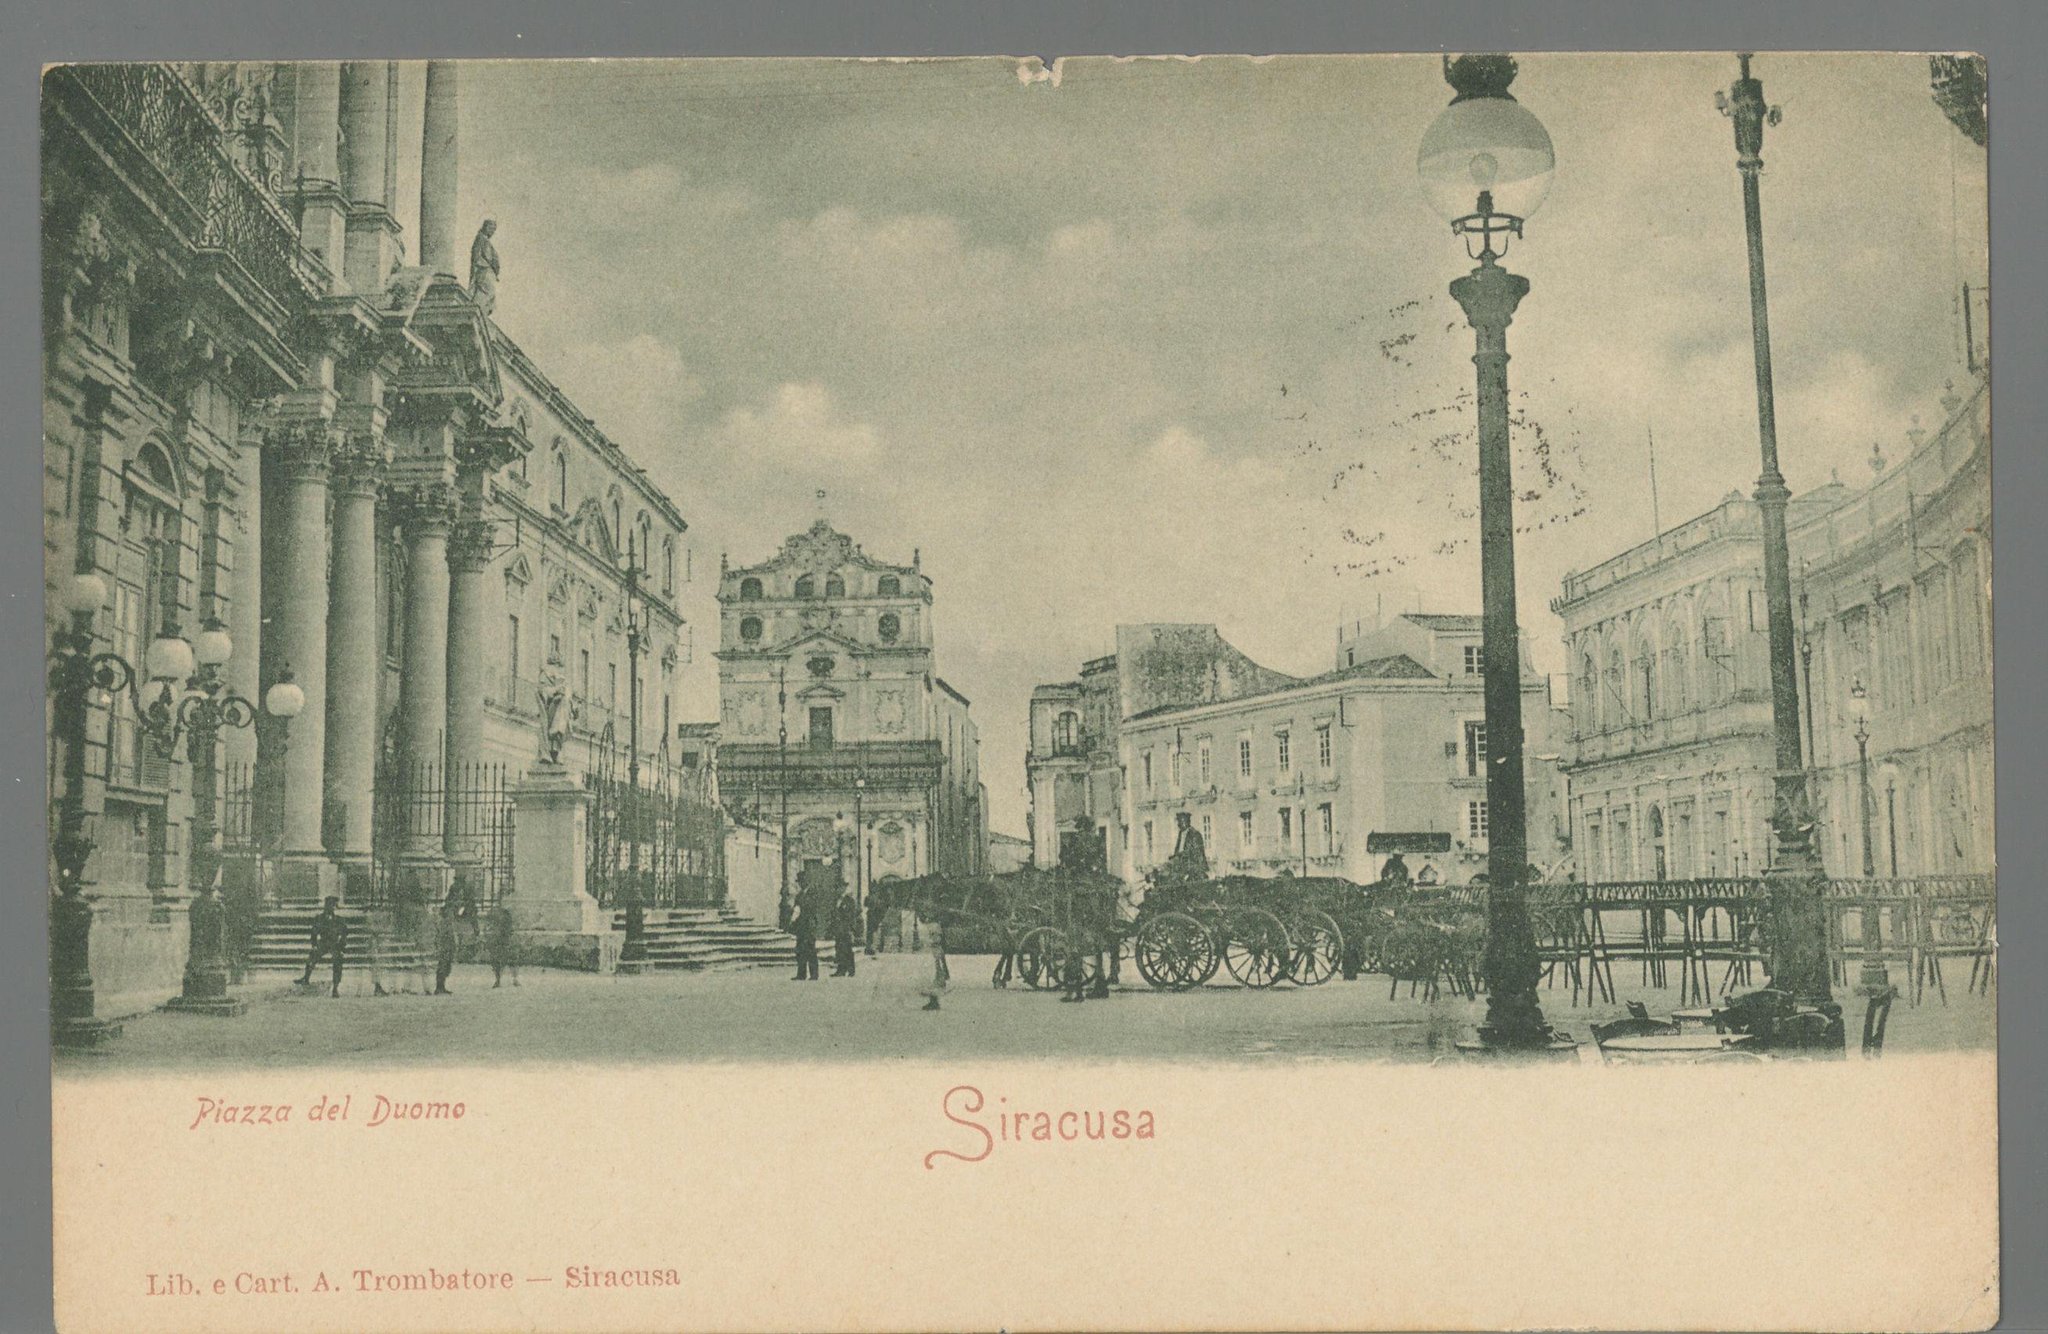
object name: ansichtkaart, prentbriefkaart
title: Piazza del Duomo. Siracusa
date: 1889-1903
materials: cardboard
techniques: photograph, writing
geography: syracuse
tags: church (exterior), square, place, circus, etc. (+ city(-scape) with figures, staffage)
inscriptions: postage stamp